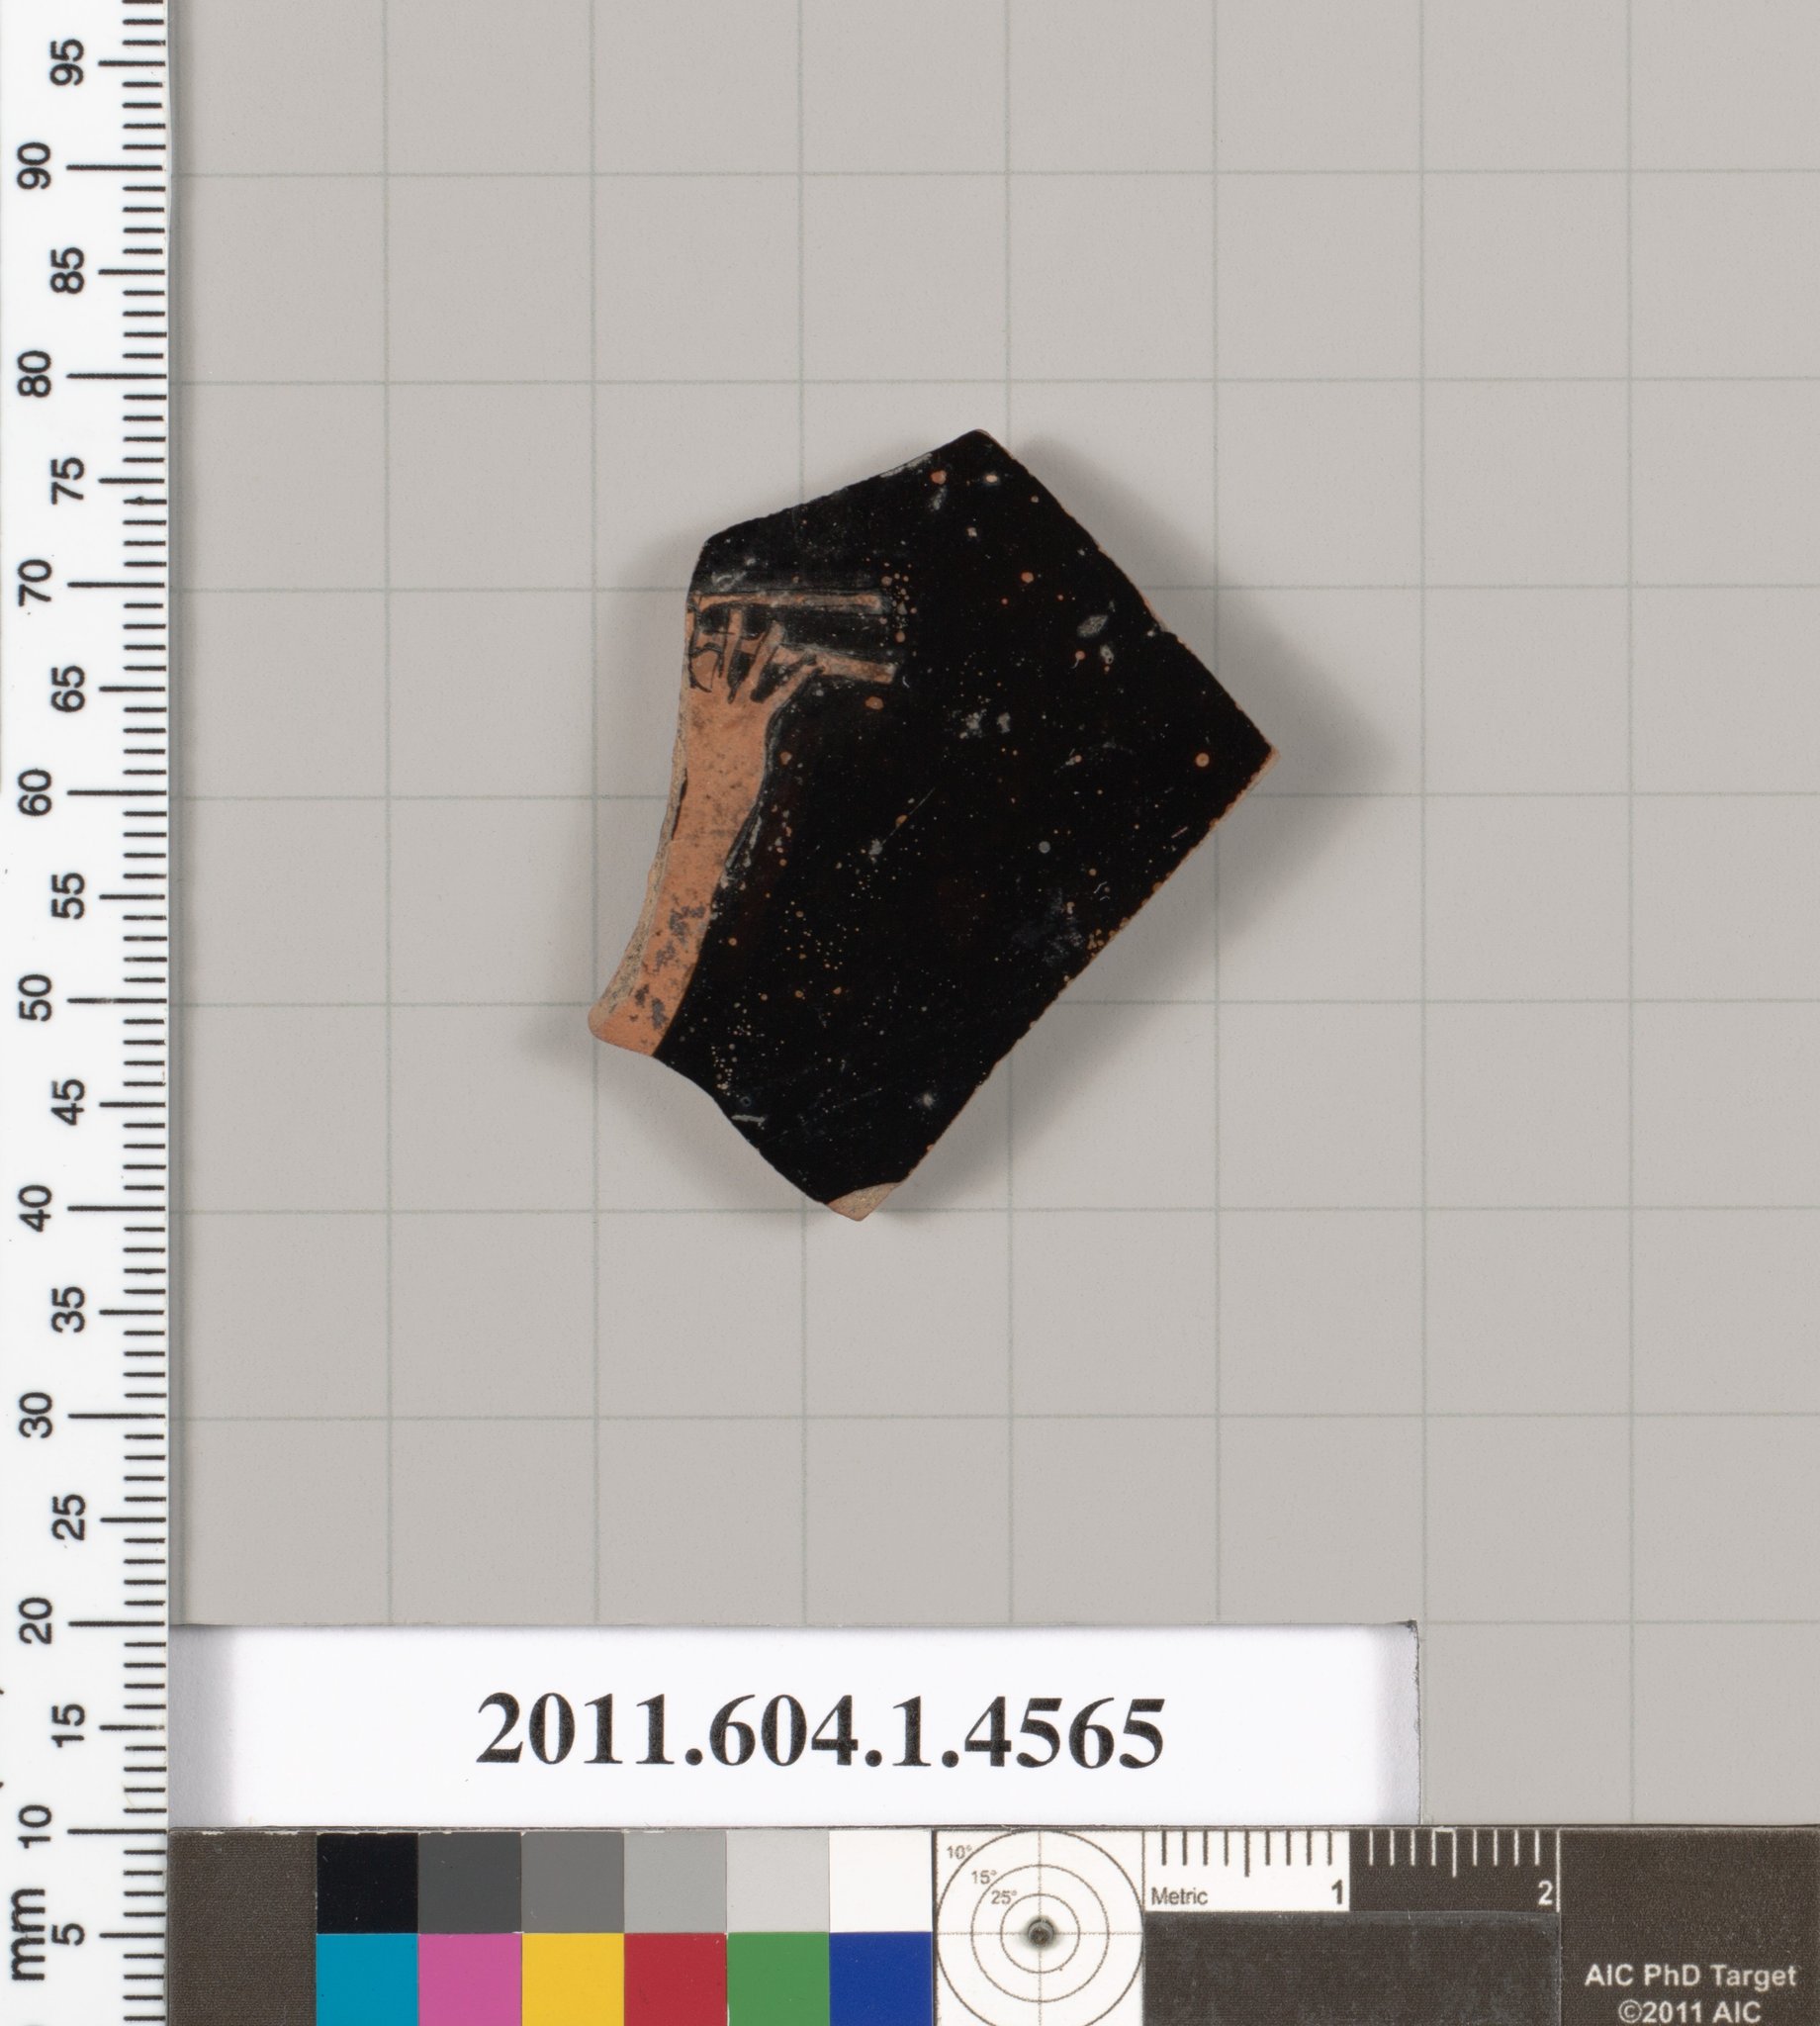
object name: kylix fragment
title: Terracotta fragment of a kylix (drinking cup)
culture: greek, attic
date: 500-480 BCE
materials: terracotta